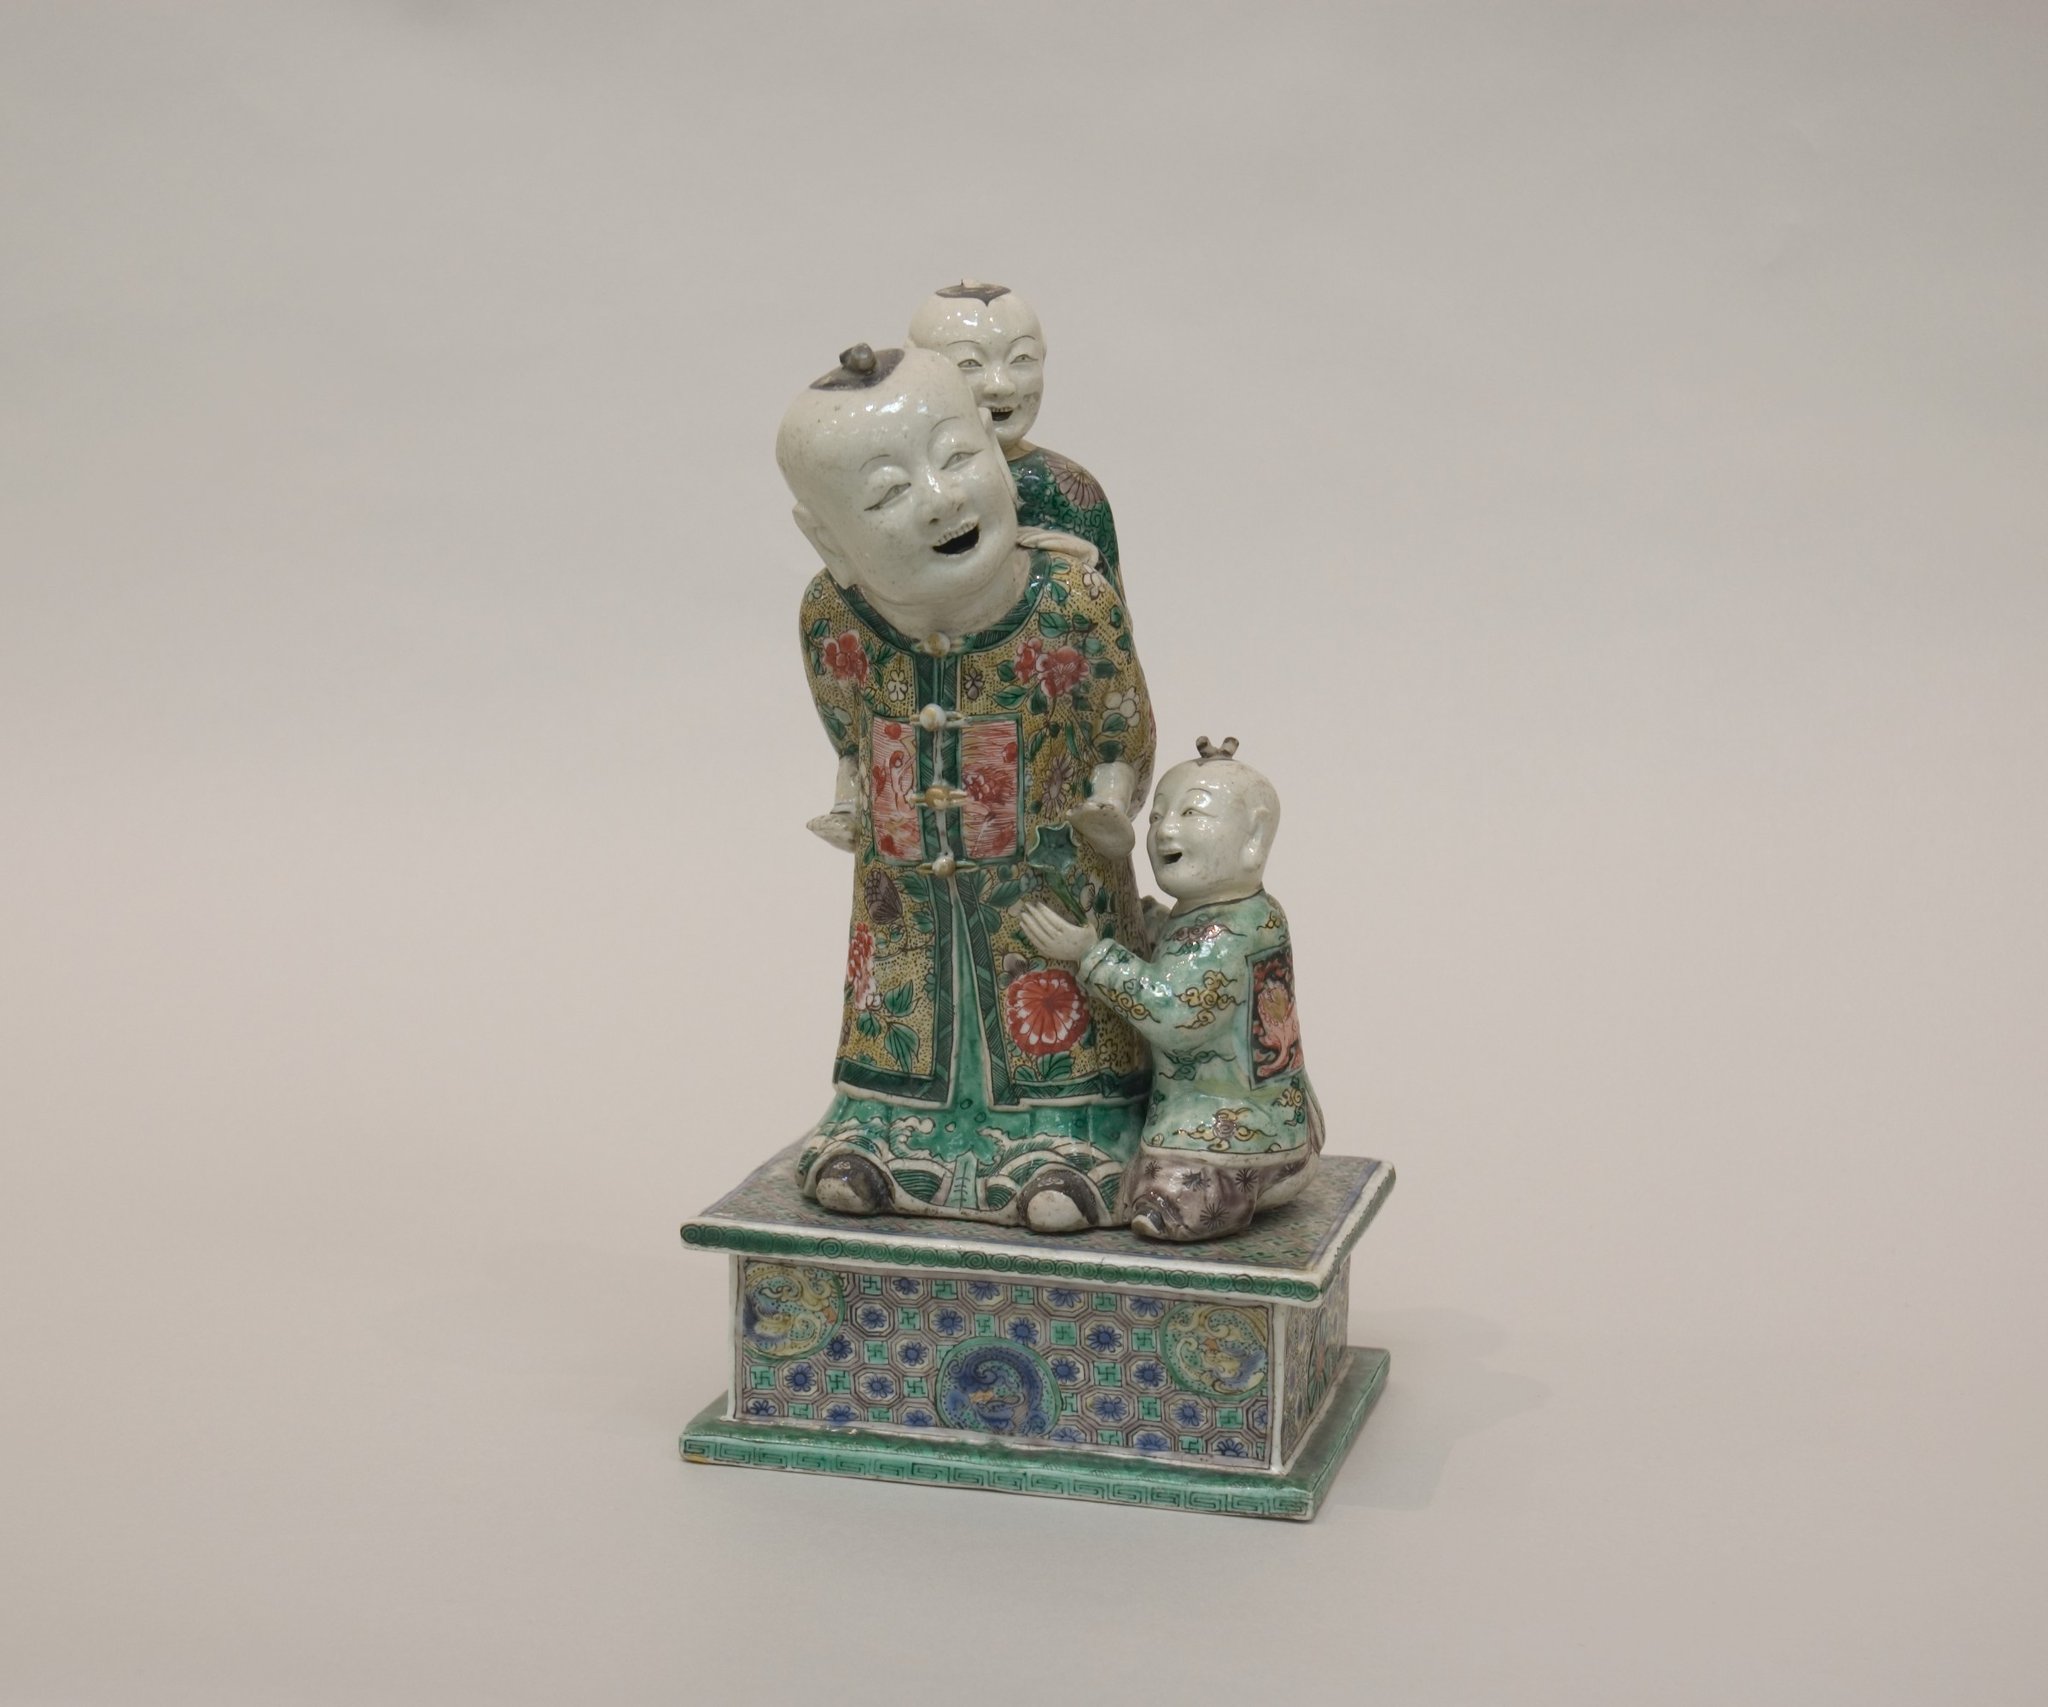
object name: group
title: Three playing boys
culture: chinese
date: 1667-1733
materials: biscuit, enamel, porcelain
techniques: painting, polychrome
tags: children,boys,playing